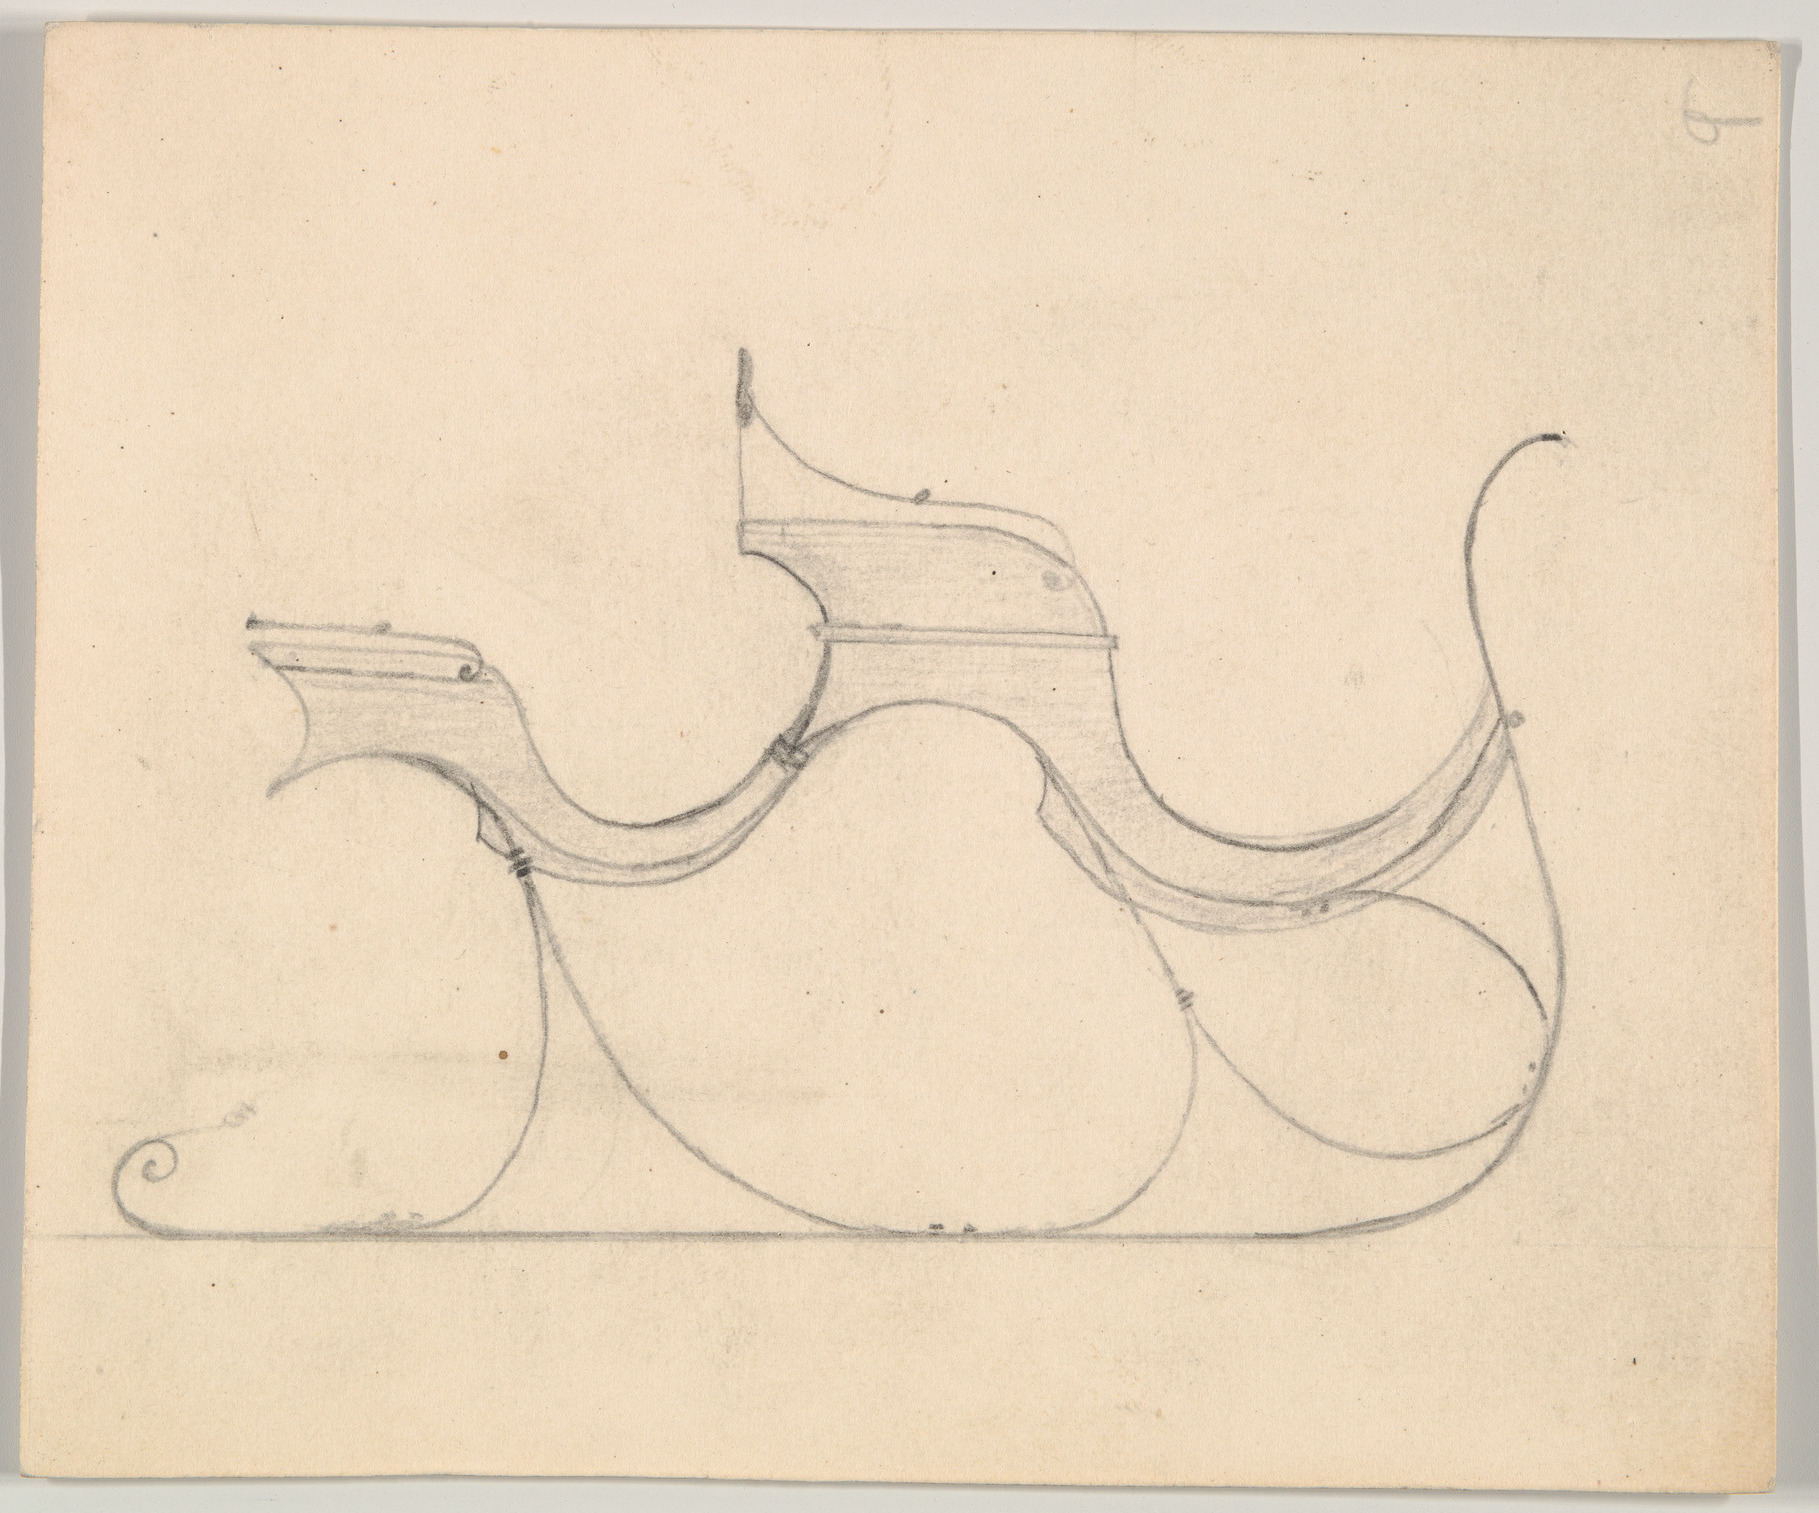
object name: drawing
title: Sleigh (unnumbered)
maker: brewster & co.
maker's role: manufacturer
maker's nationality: american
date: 1877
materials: graphite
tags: carriages